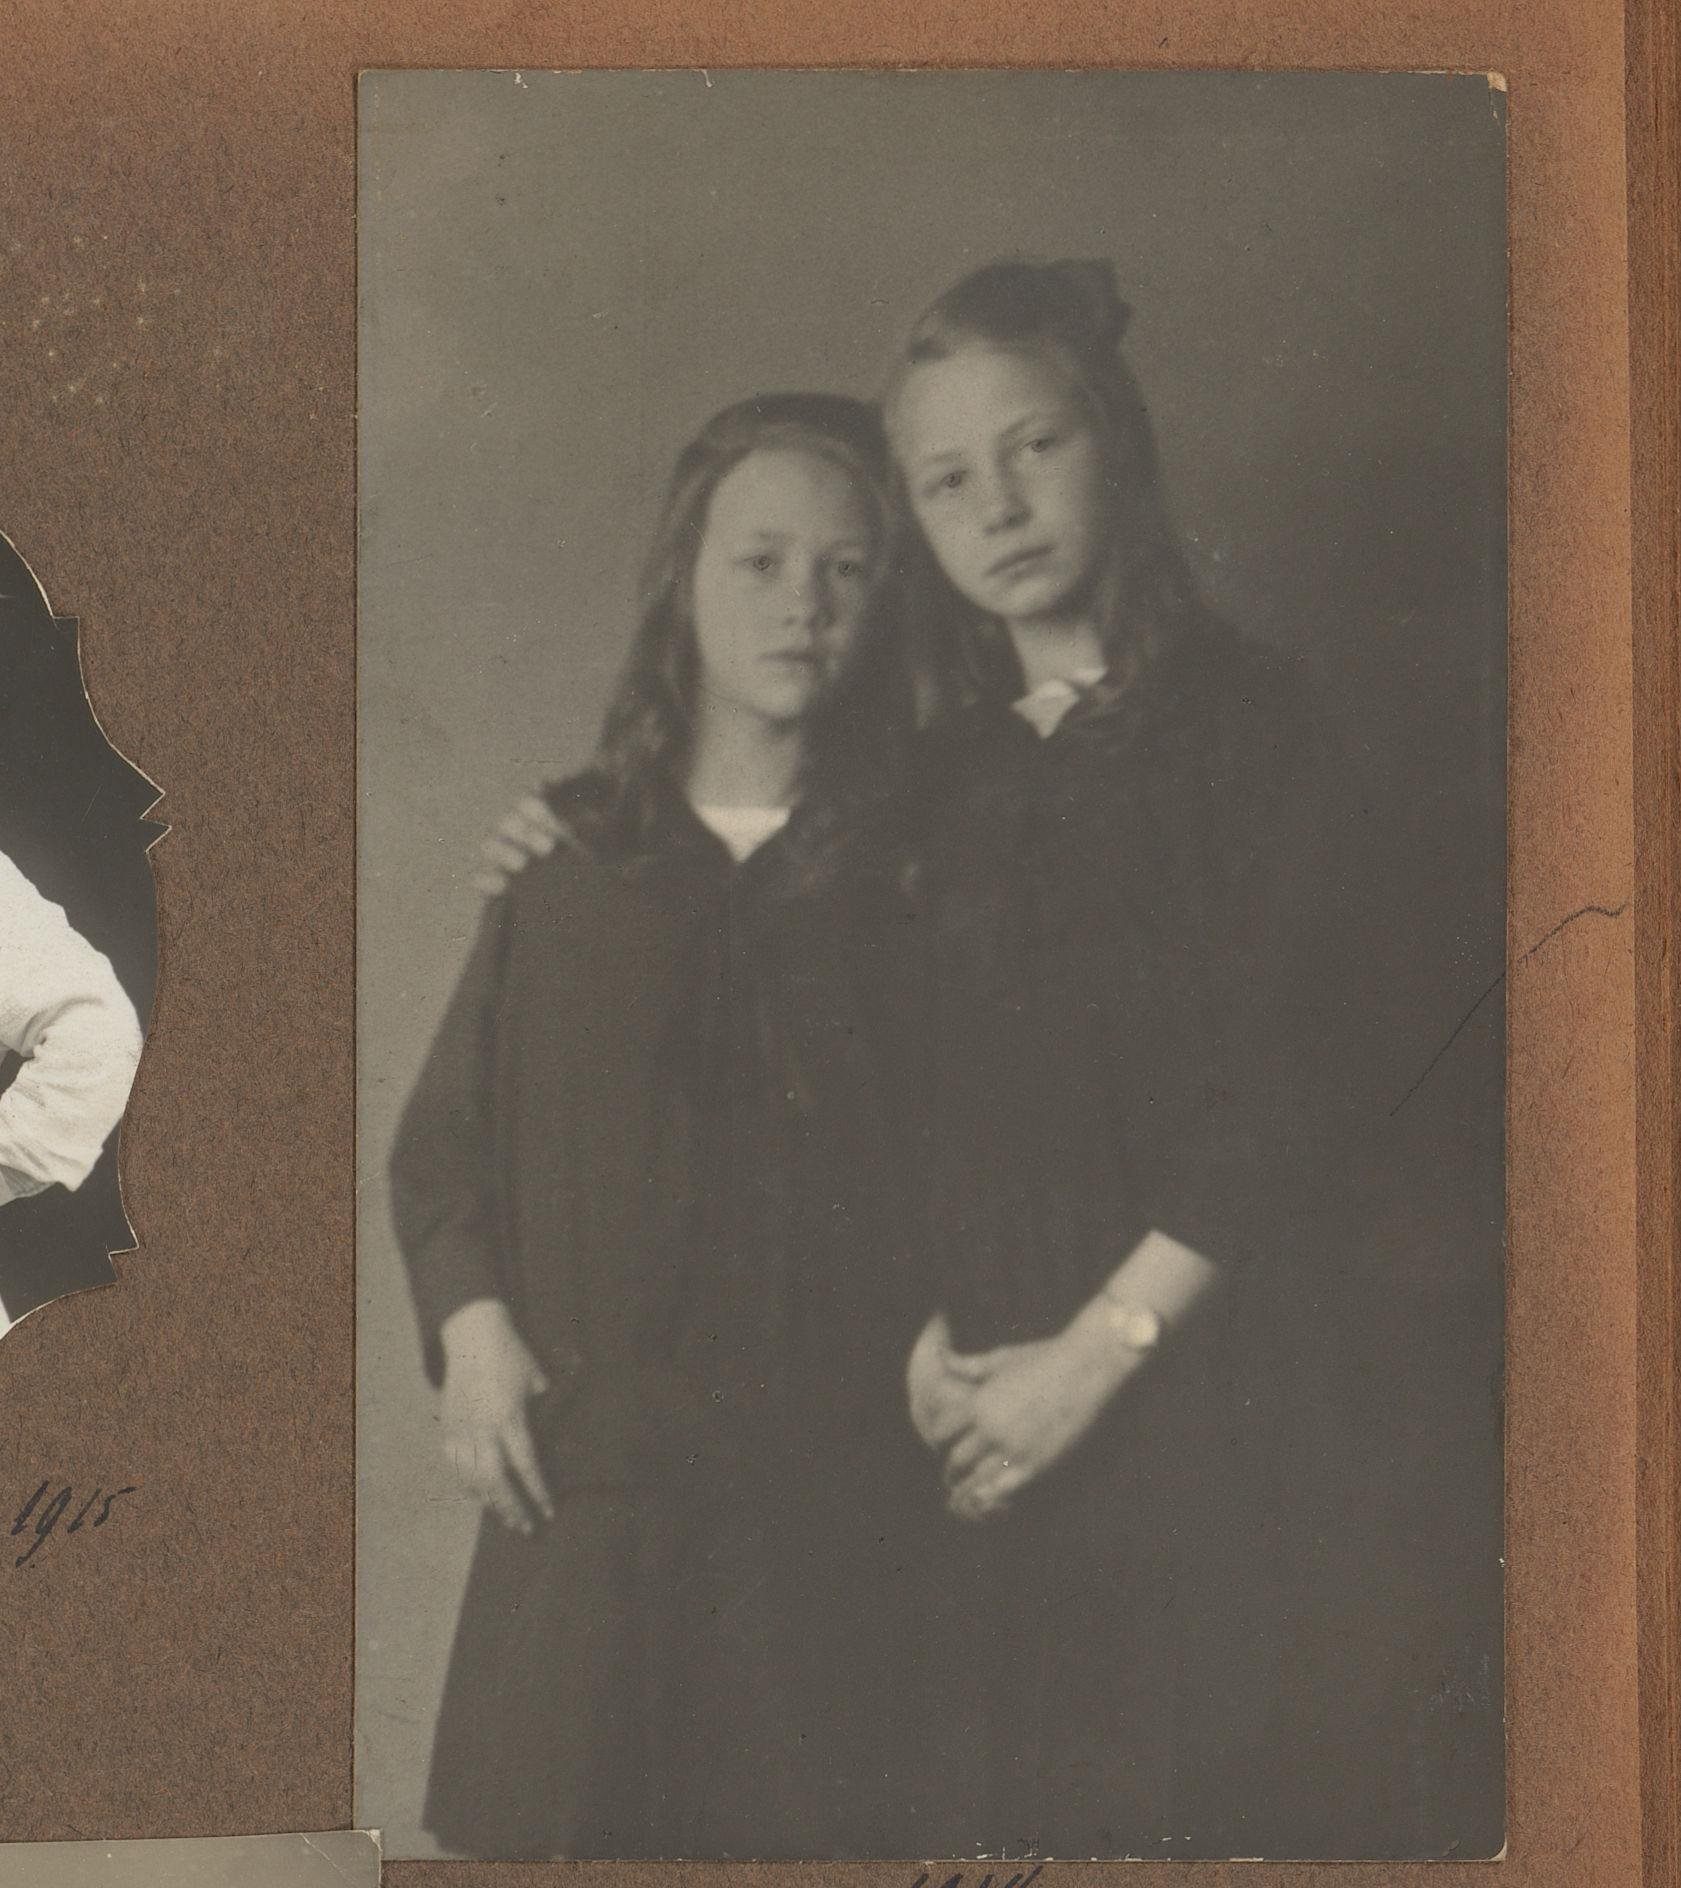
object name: photograph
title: Thea en Joanna Diepenbrock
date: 1914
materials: photographic support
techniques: photography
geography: amsterdam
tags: amsterdam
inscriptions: date: ‘1914’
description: Foto op bruin albumblad 27 van familiealbum van Alphons Diepenbrock.